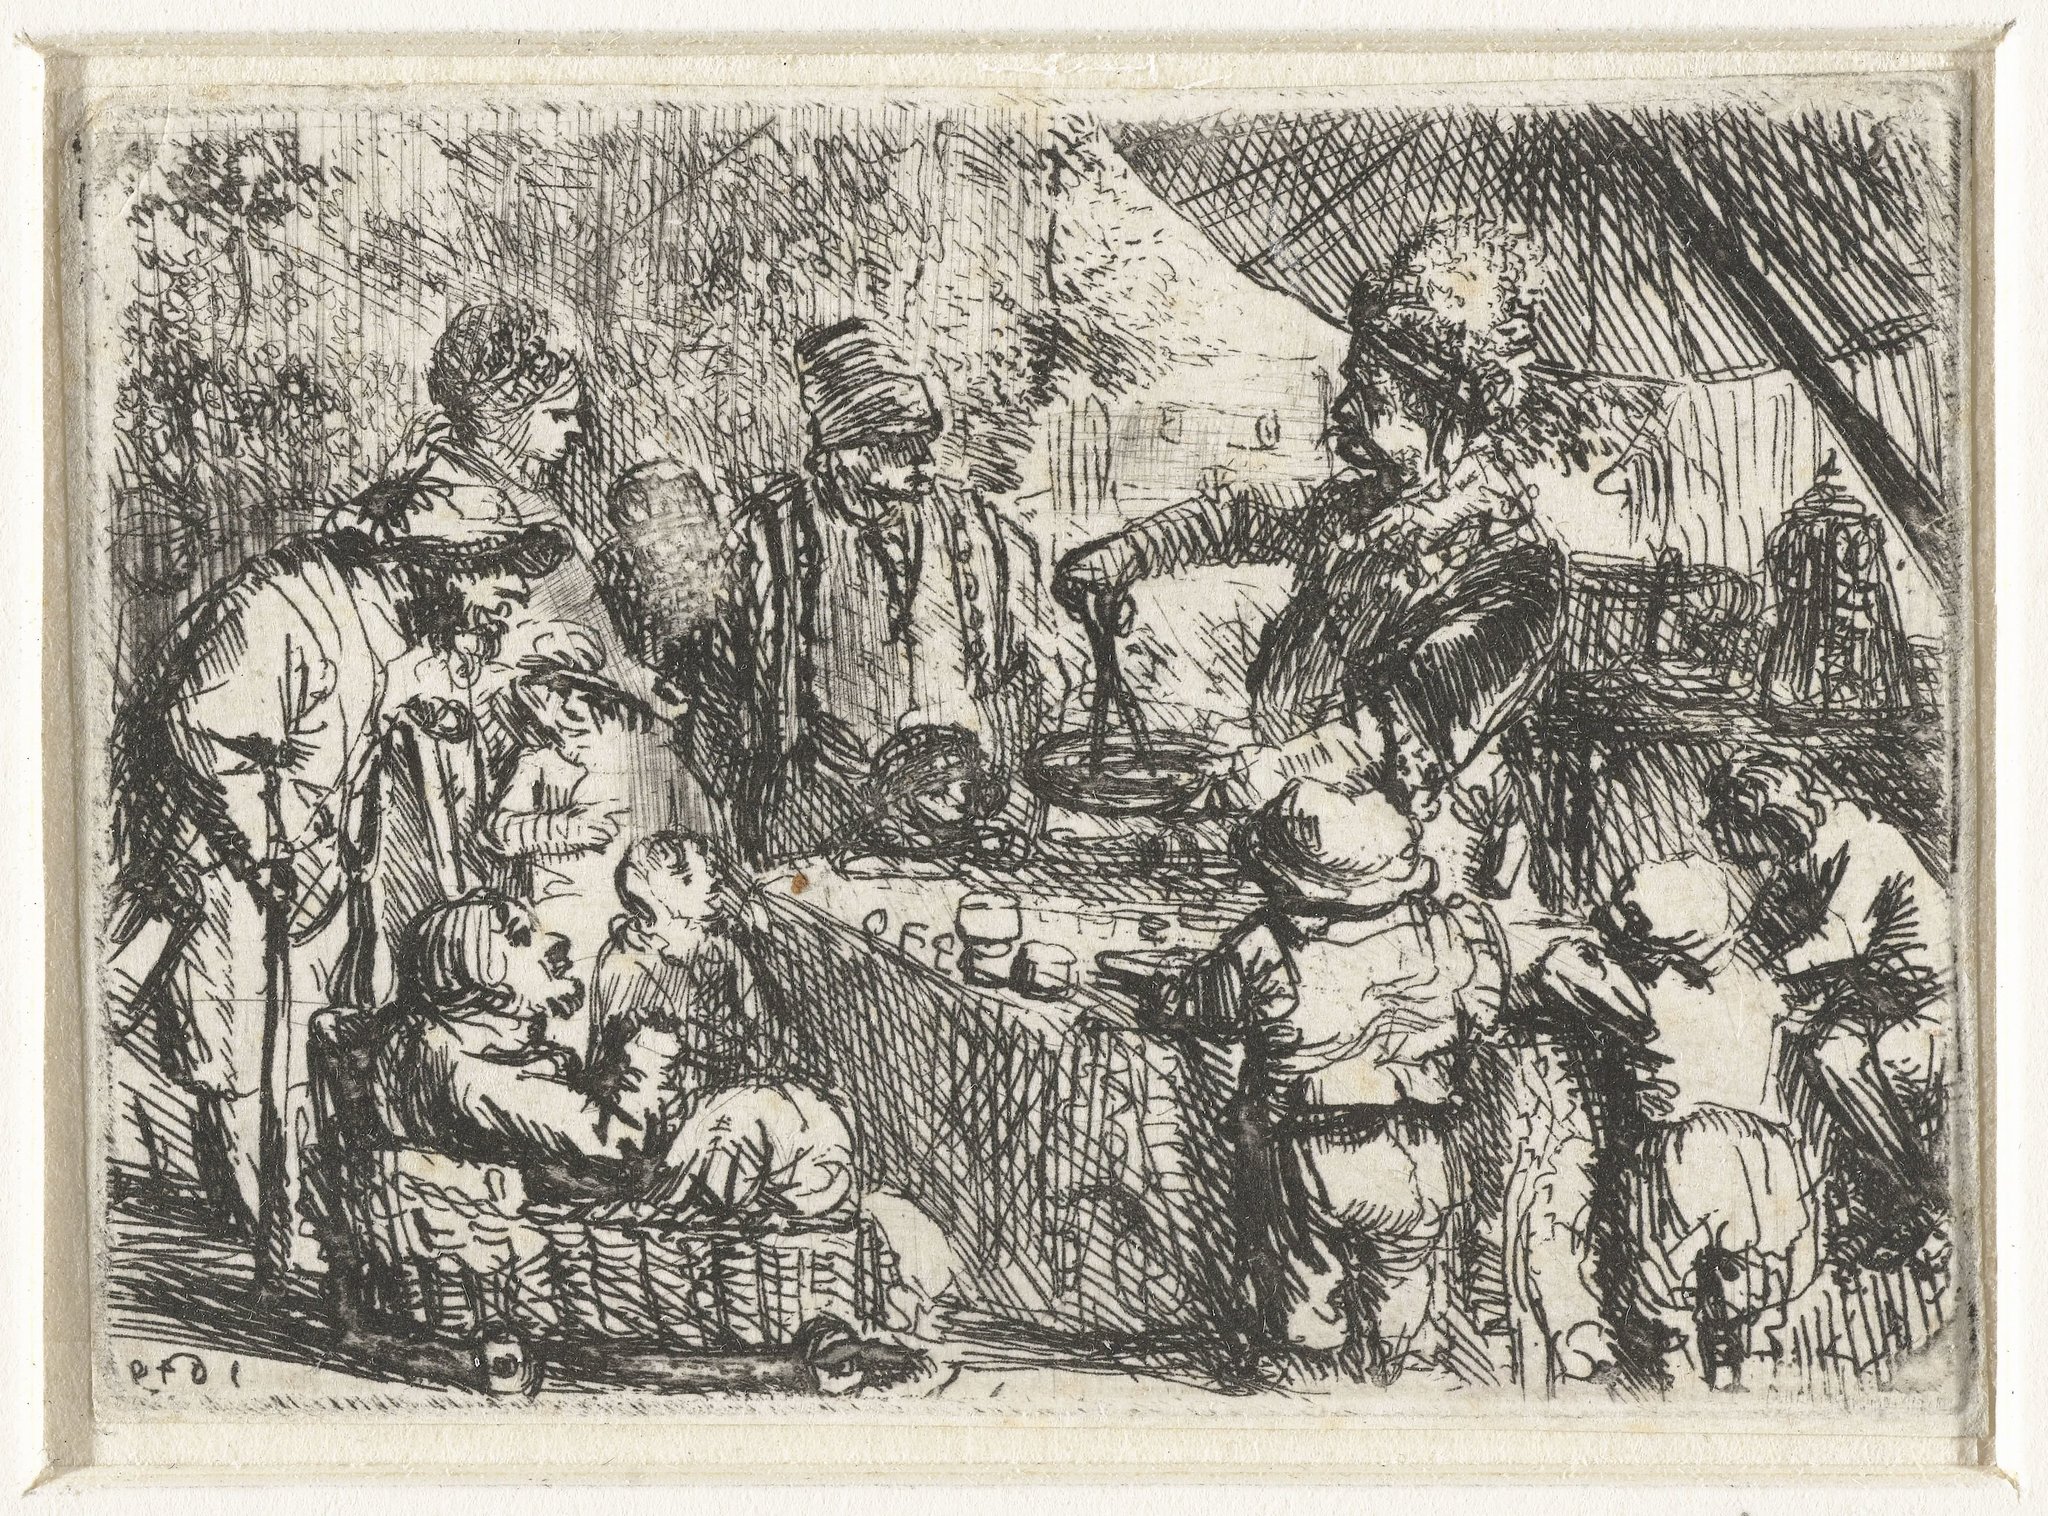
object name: print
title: Goochelaar onder een parasol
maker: constantijn à renesse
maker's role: draughtsman, print maker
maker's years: 1626-1680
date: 1649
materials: paper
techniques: drypoint, etching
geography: netherlands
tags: quack, charlatan, mountebank, 'saltimbanco'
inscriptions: collector's mark: Lugt 240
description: Een googchelaar of kwakzalver staand onder een parasol bij een tafel met objecten. Rond de tafel een aantal toehoorders.